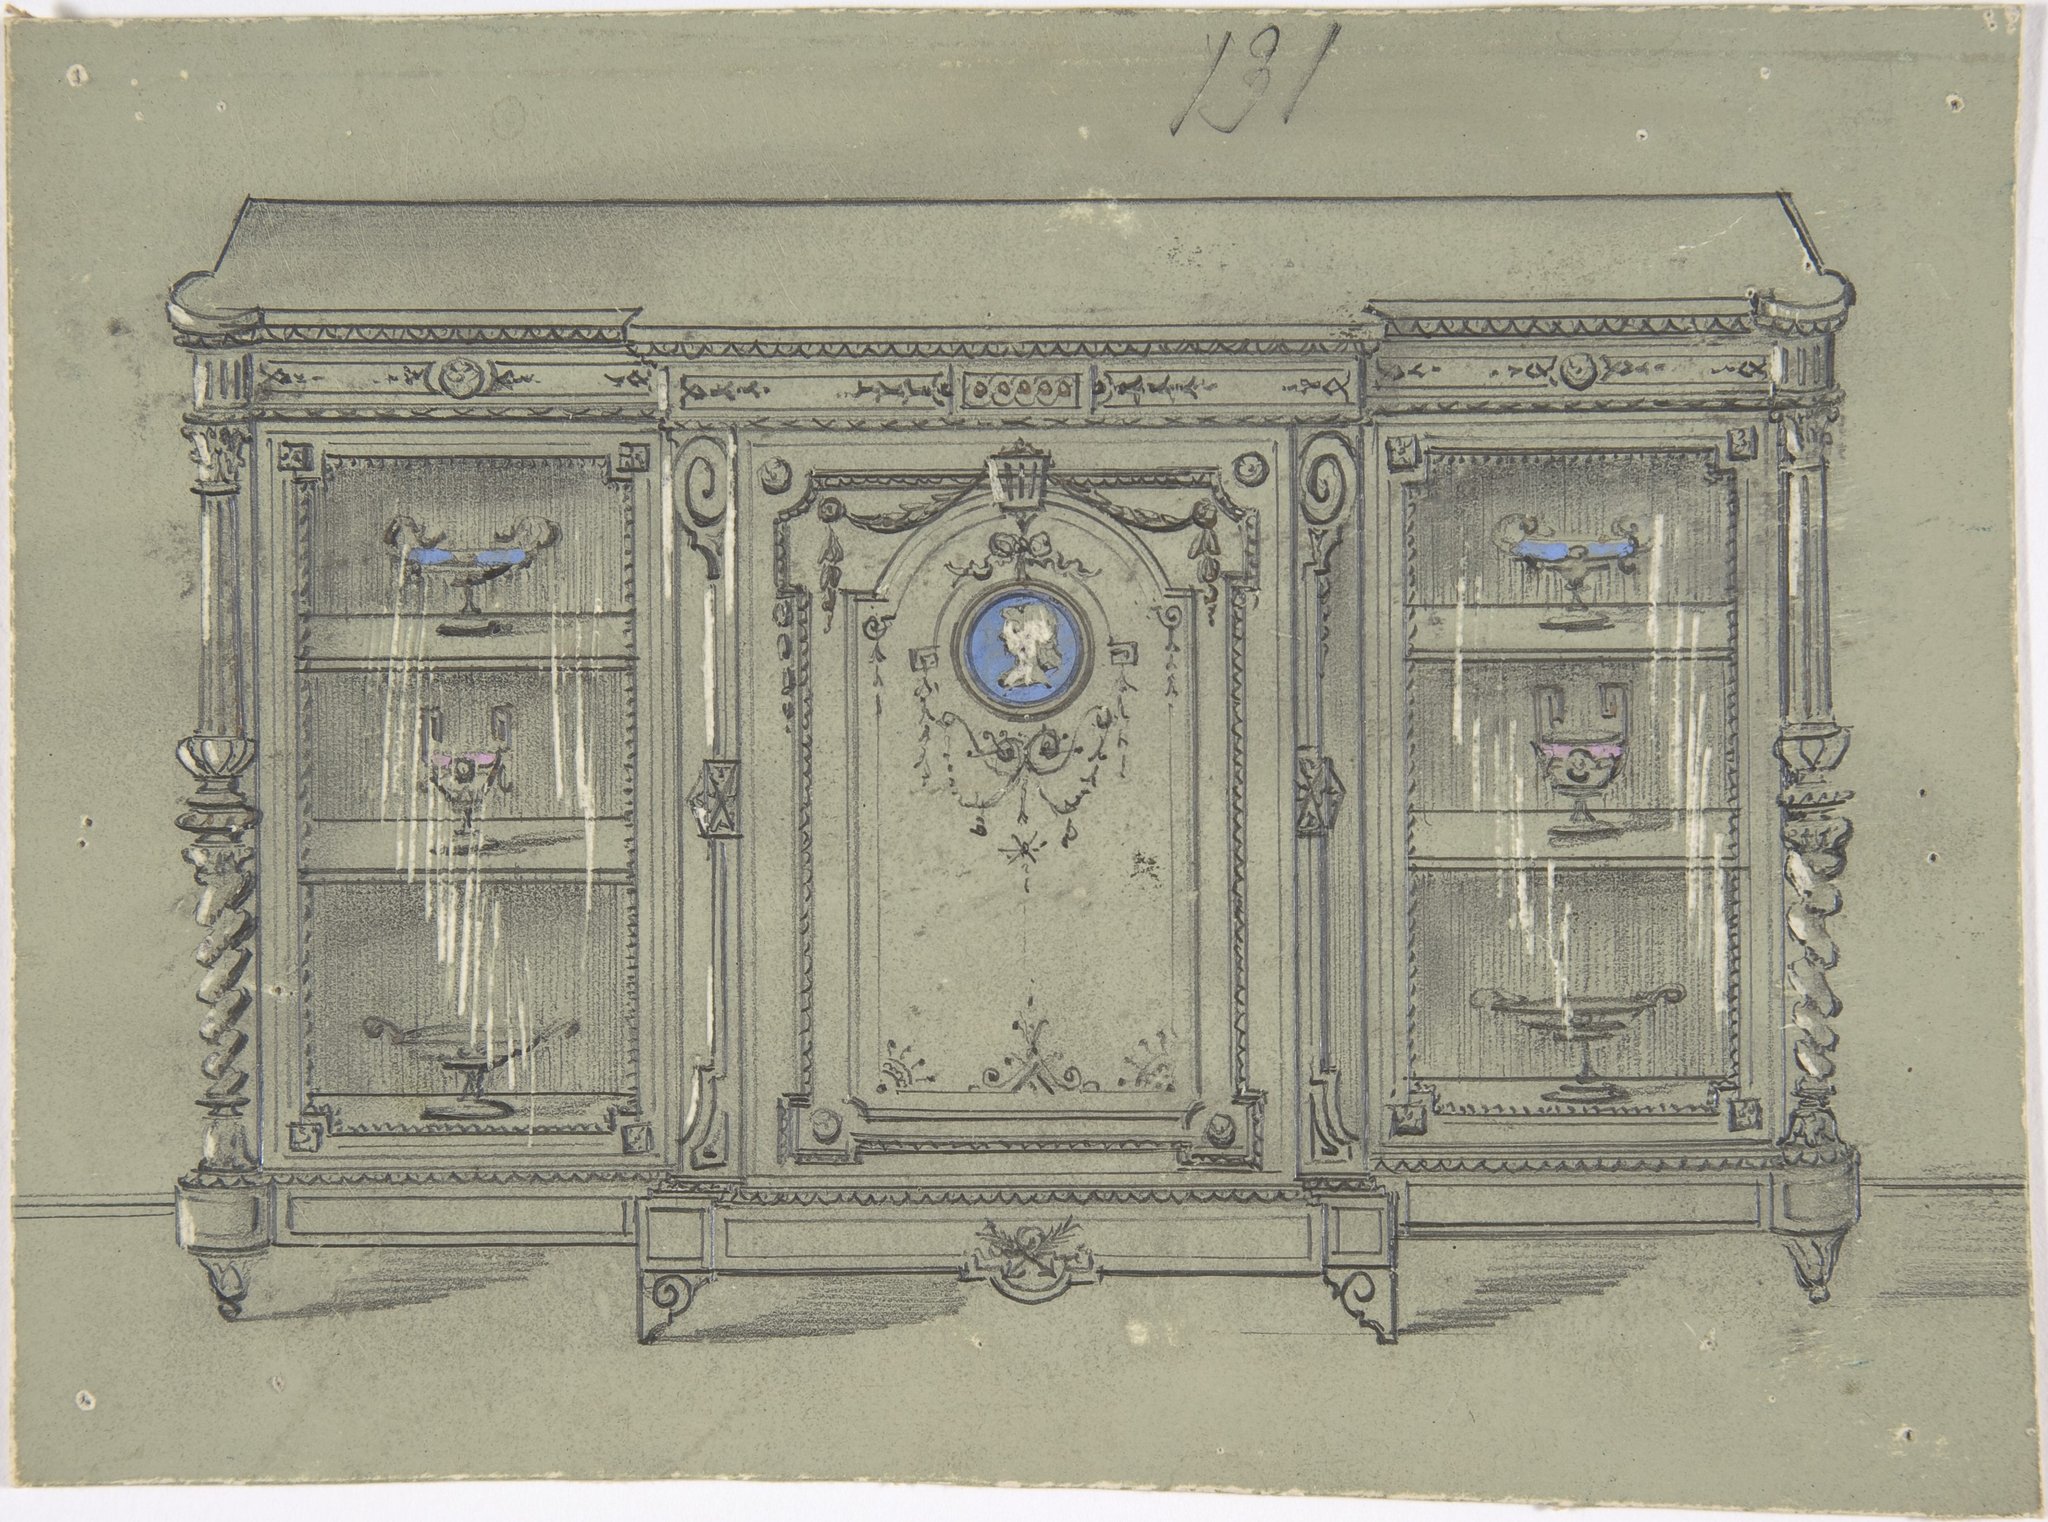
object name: drawing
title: Design for a Cabinet with Glass Doors and a Porcelain Plaque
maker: anonymous, british, 19th century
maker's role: artist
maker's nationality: british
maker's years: 1800-1900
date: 1801-1900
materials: graphite, watercolor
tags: cabinets